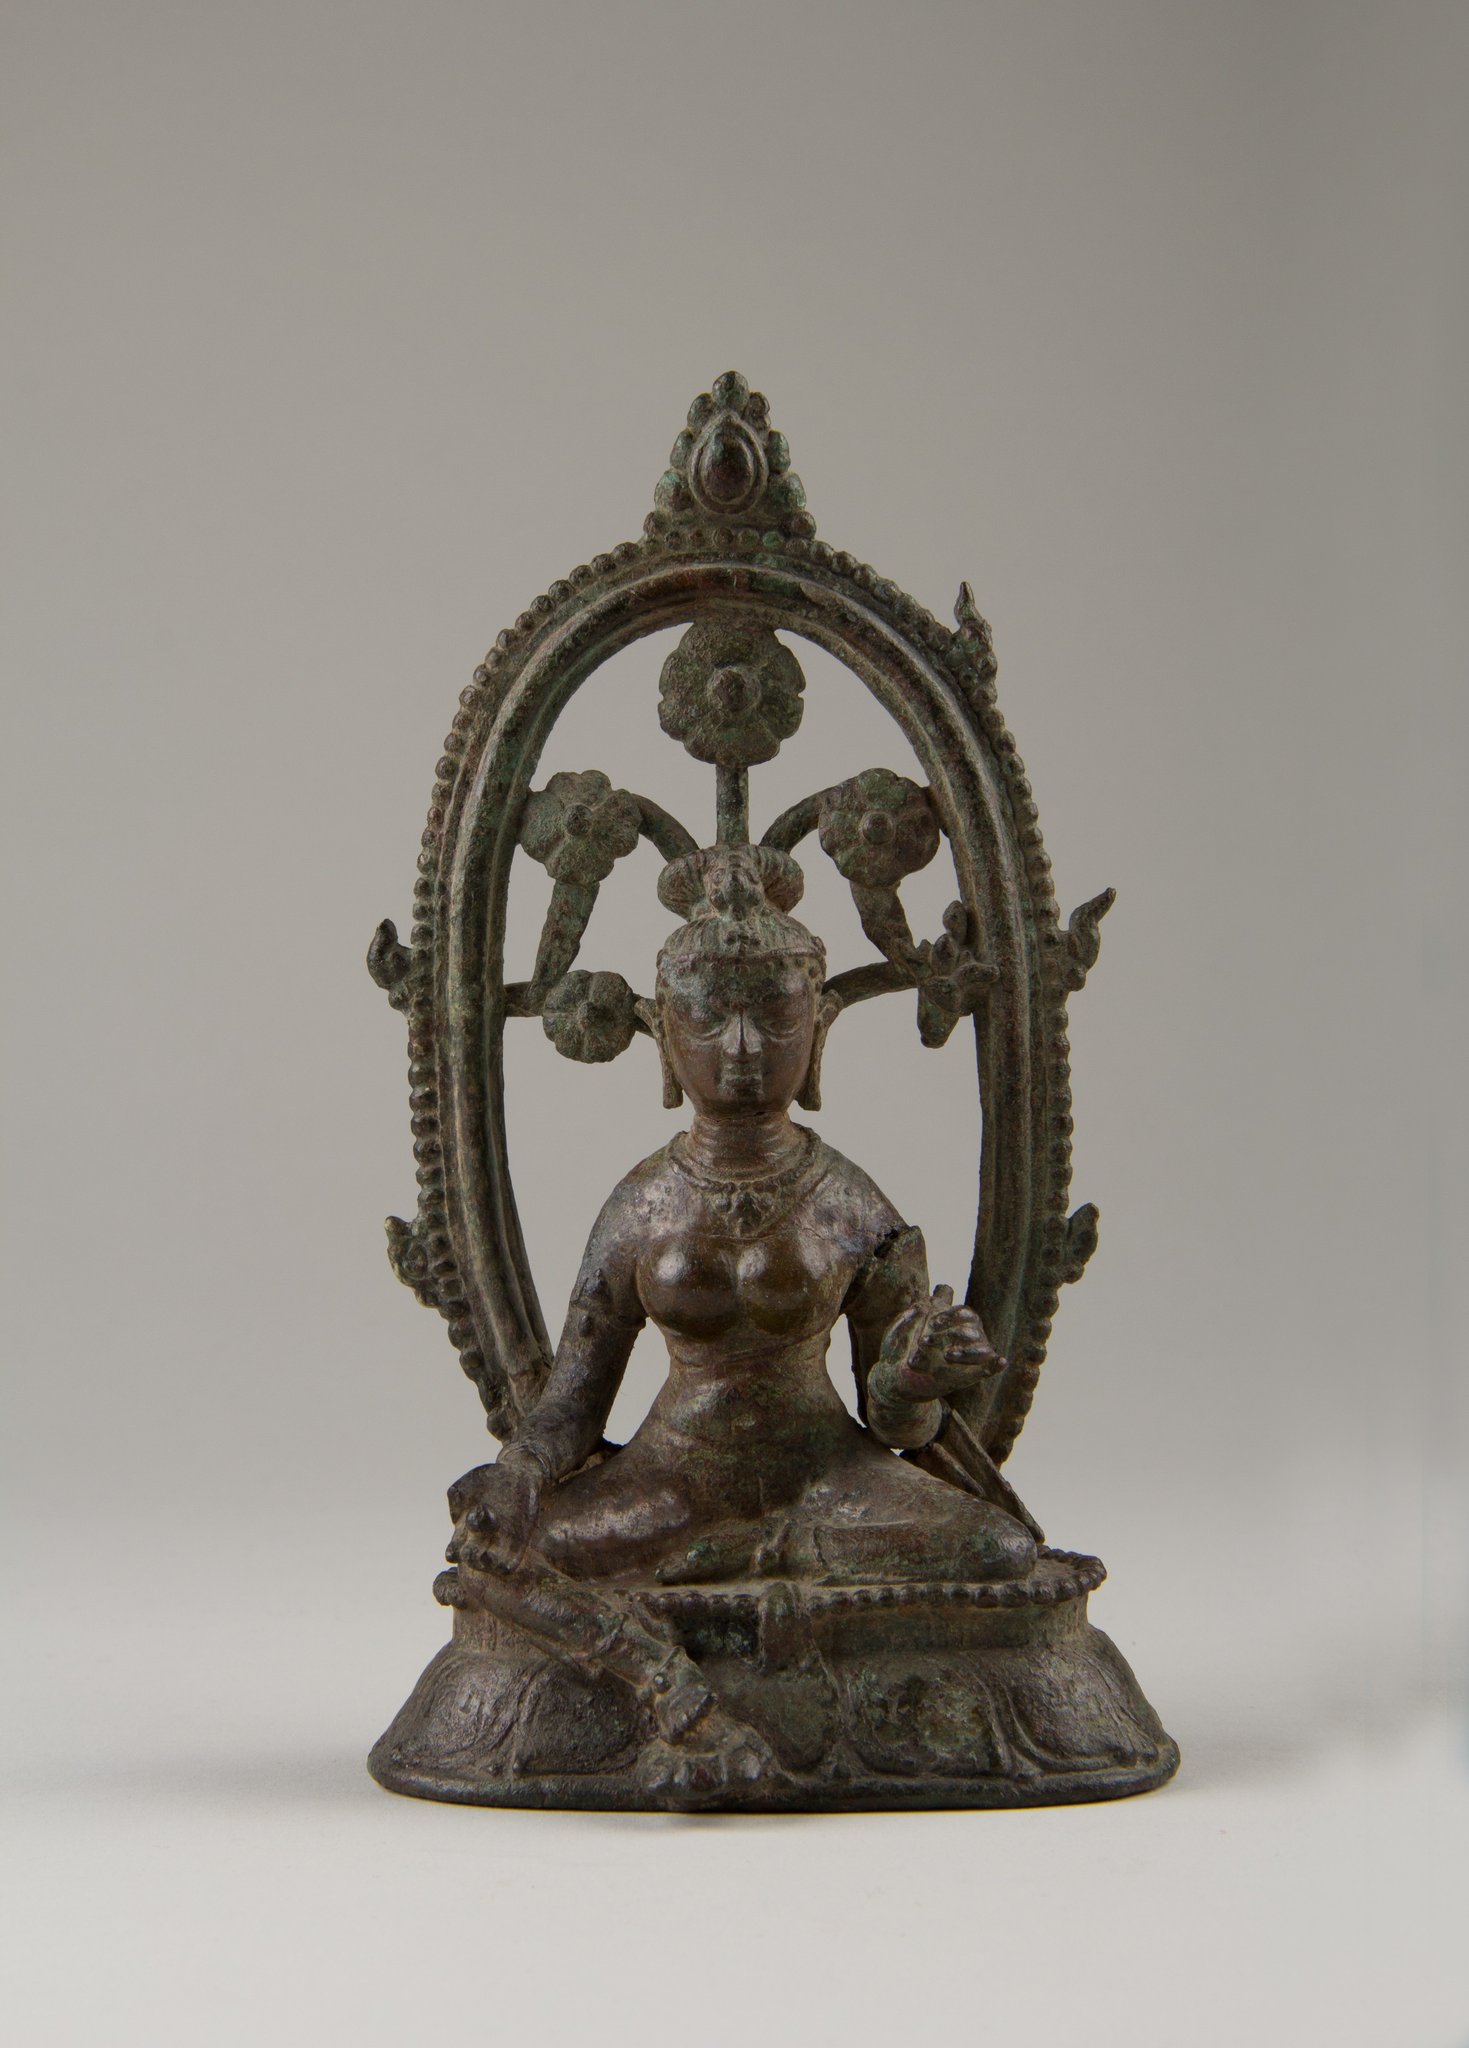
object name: figure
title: Tara, the Buddhist Savioress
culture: bangladeshi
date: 751-800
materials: bronze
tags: buddhism,deities